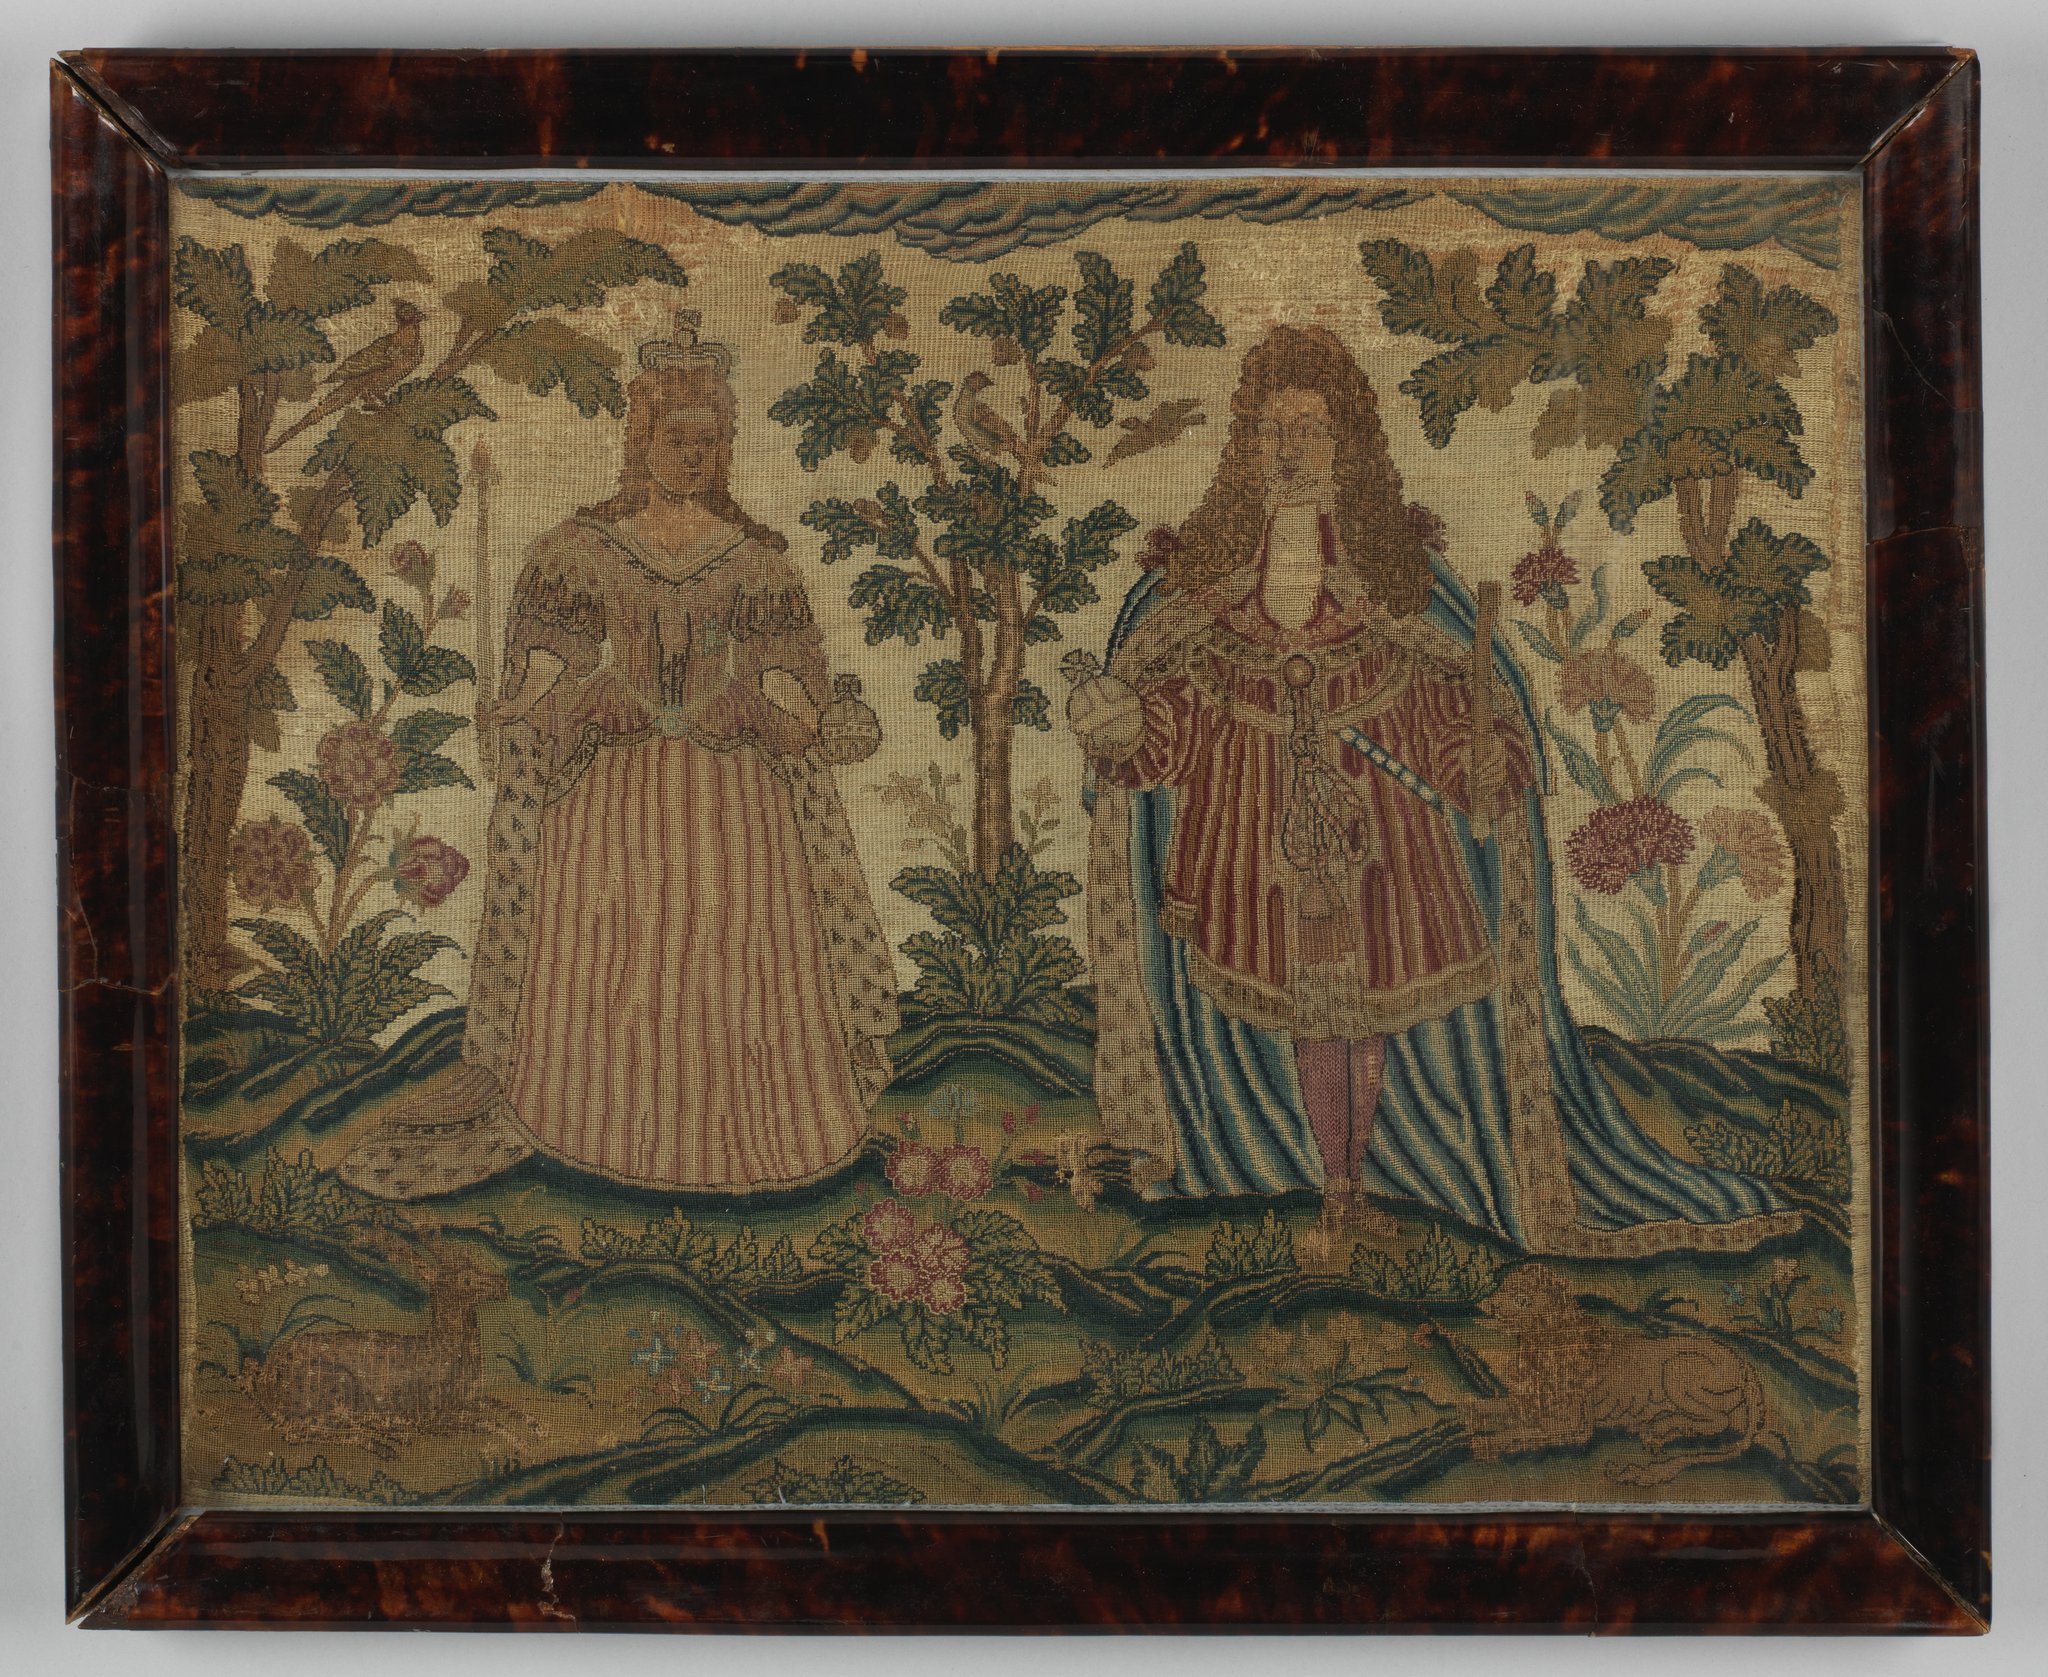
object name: portrait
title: Portrait of William and Mary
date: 1667-1733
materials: linen, thread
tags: birds,kings,queens,men,women,deer,lions